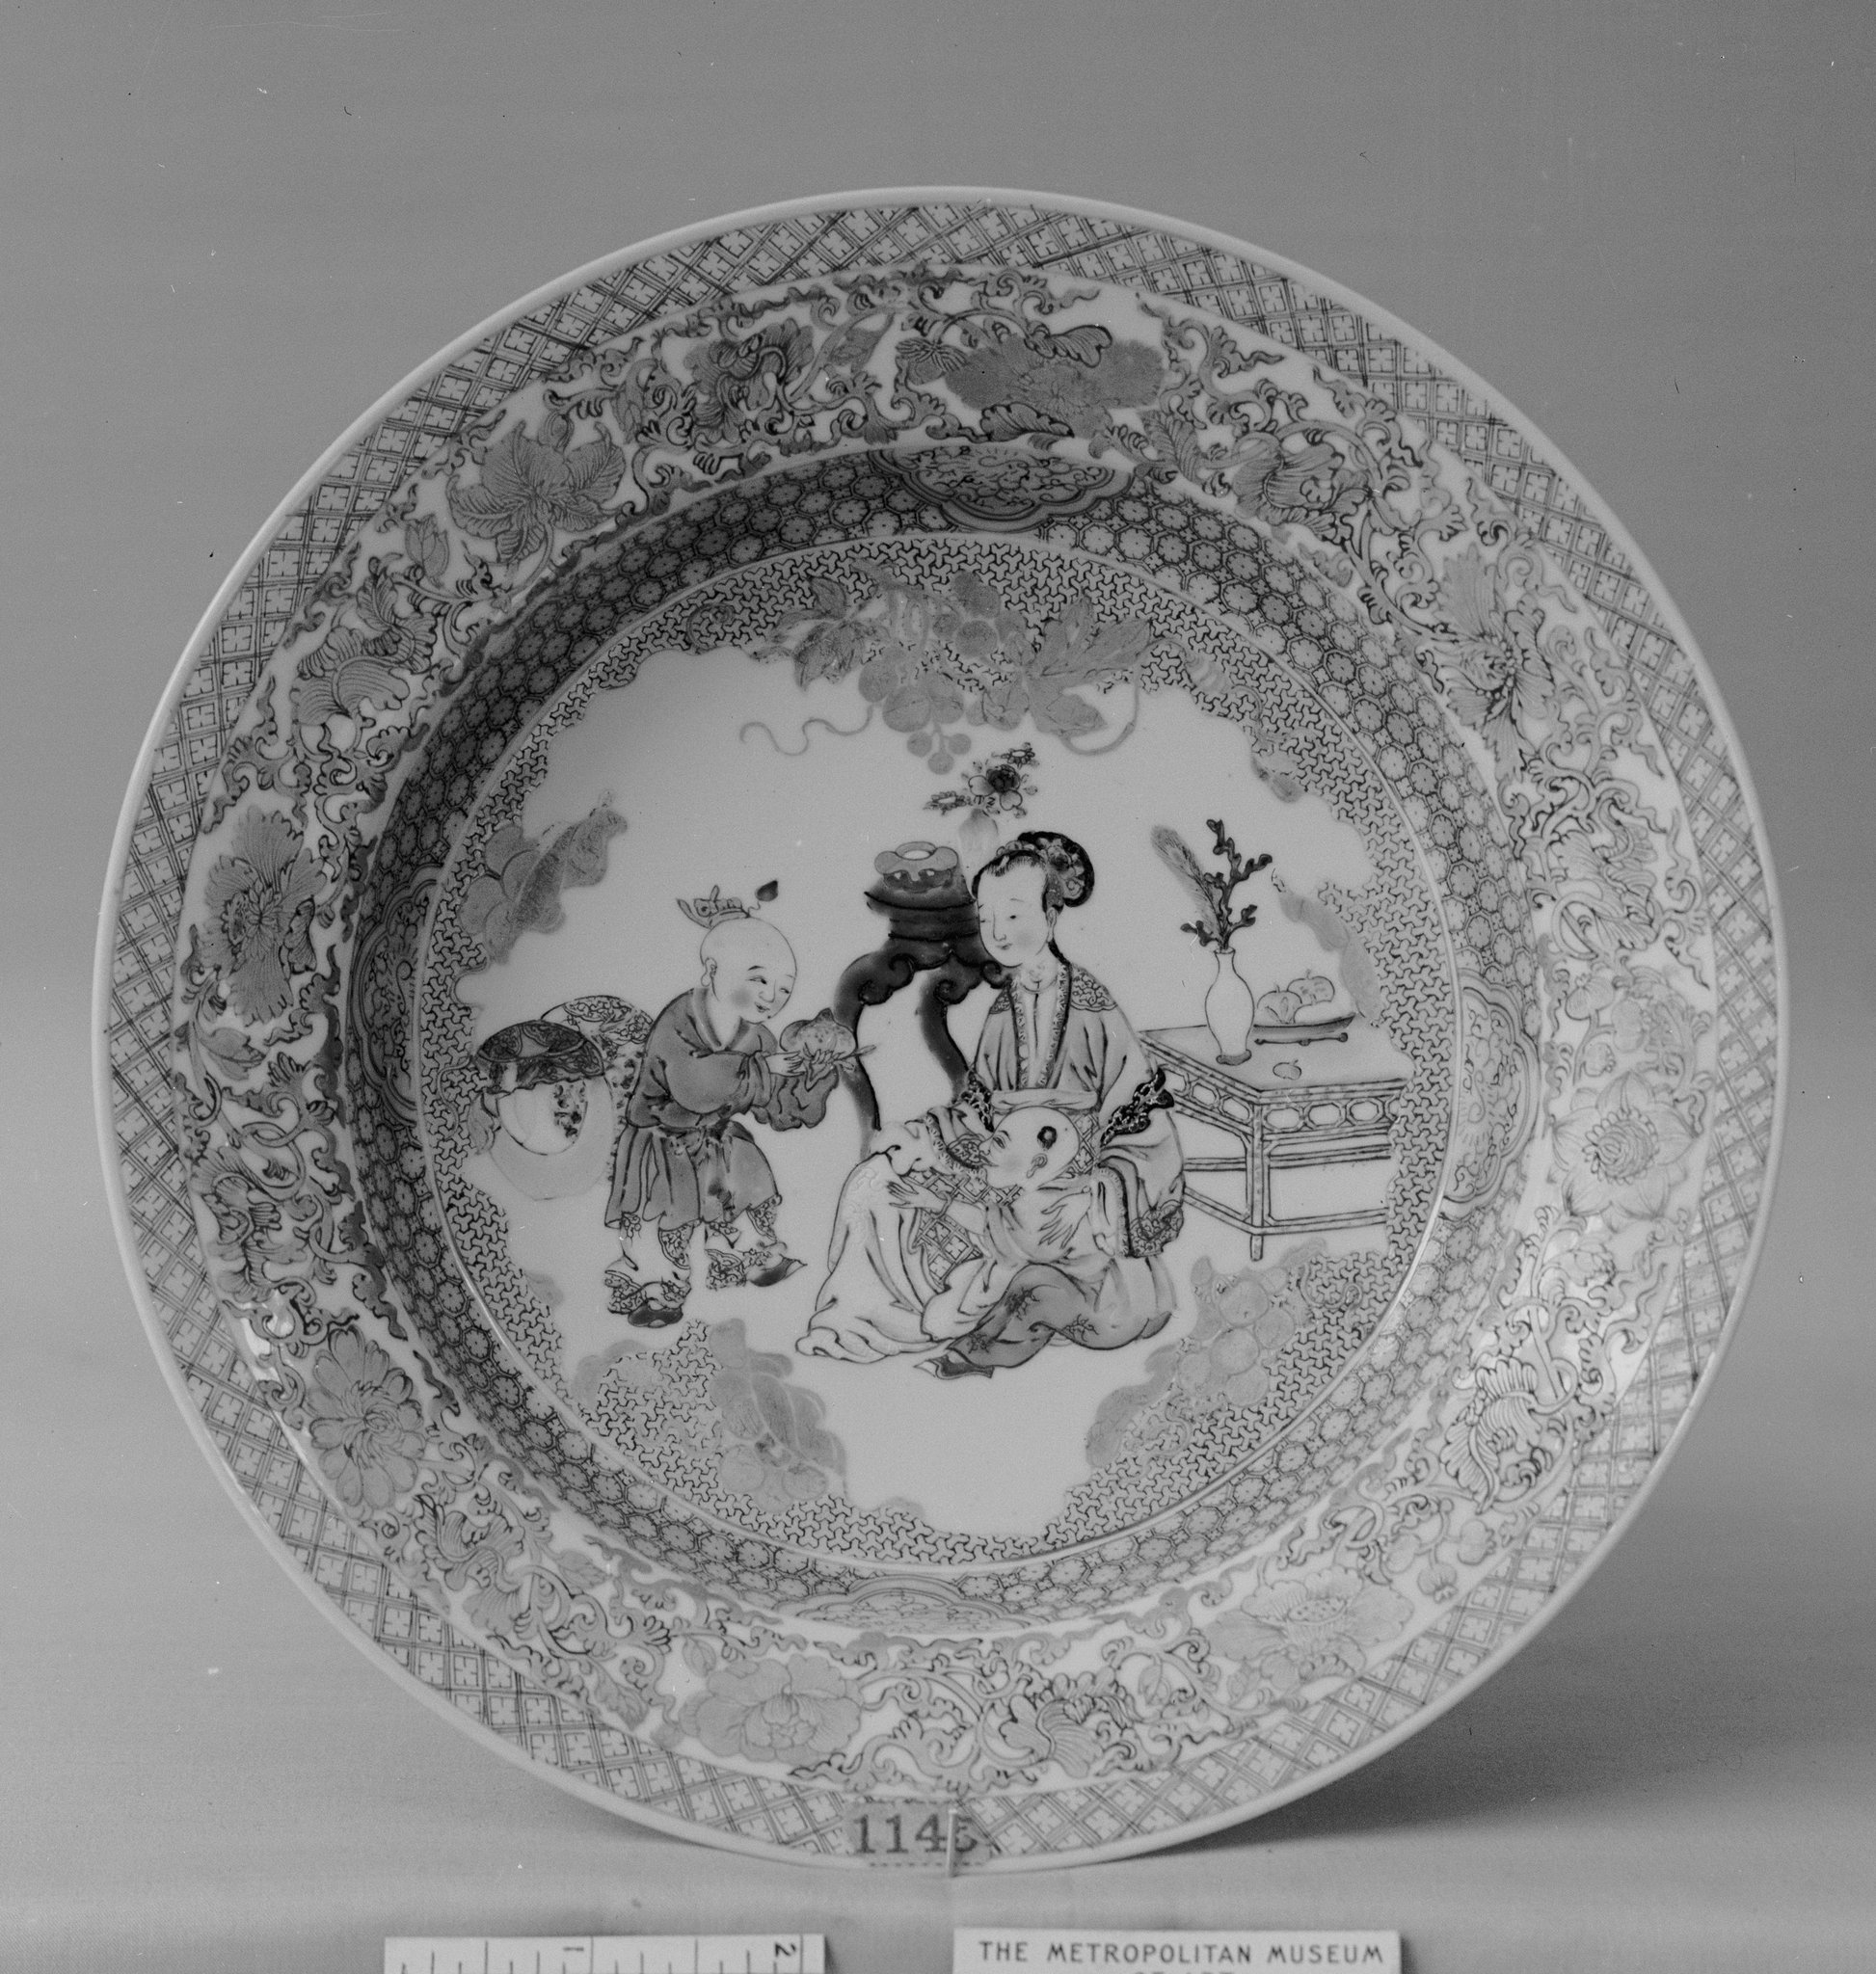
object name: plate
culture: chinese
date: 1730-1750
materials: enamel, gilt, porcelain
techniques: overglaze, painting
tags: children,women,flowers